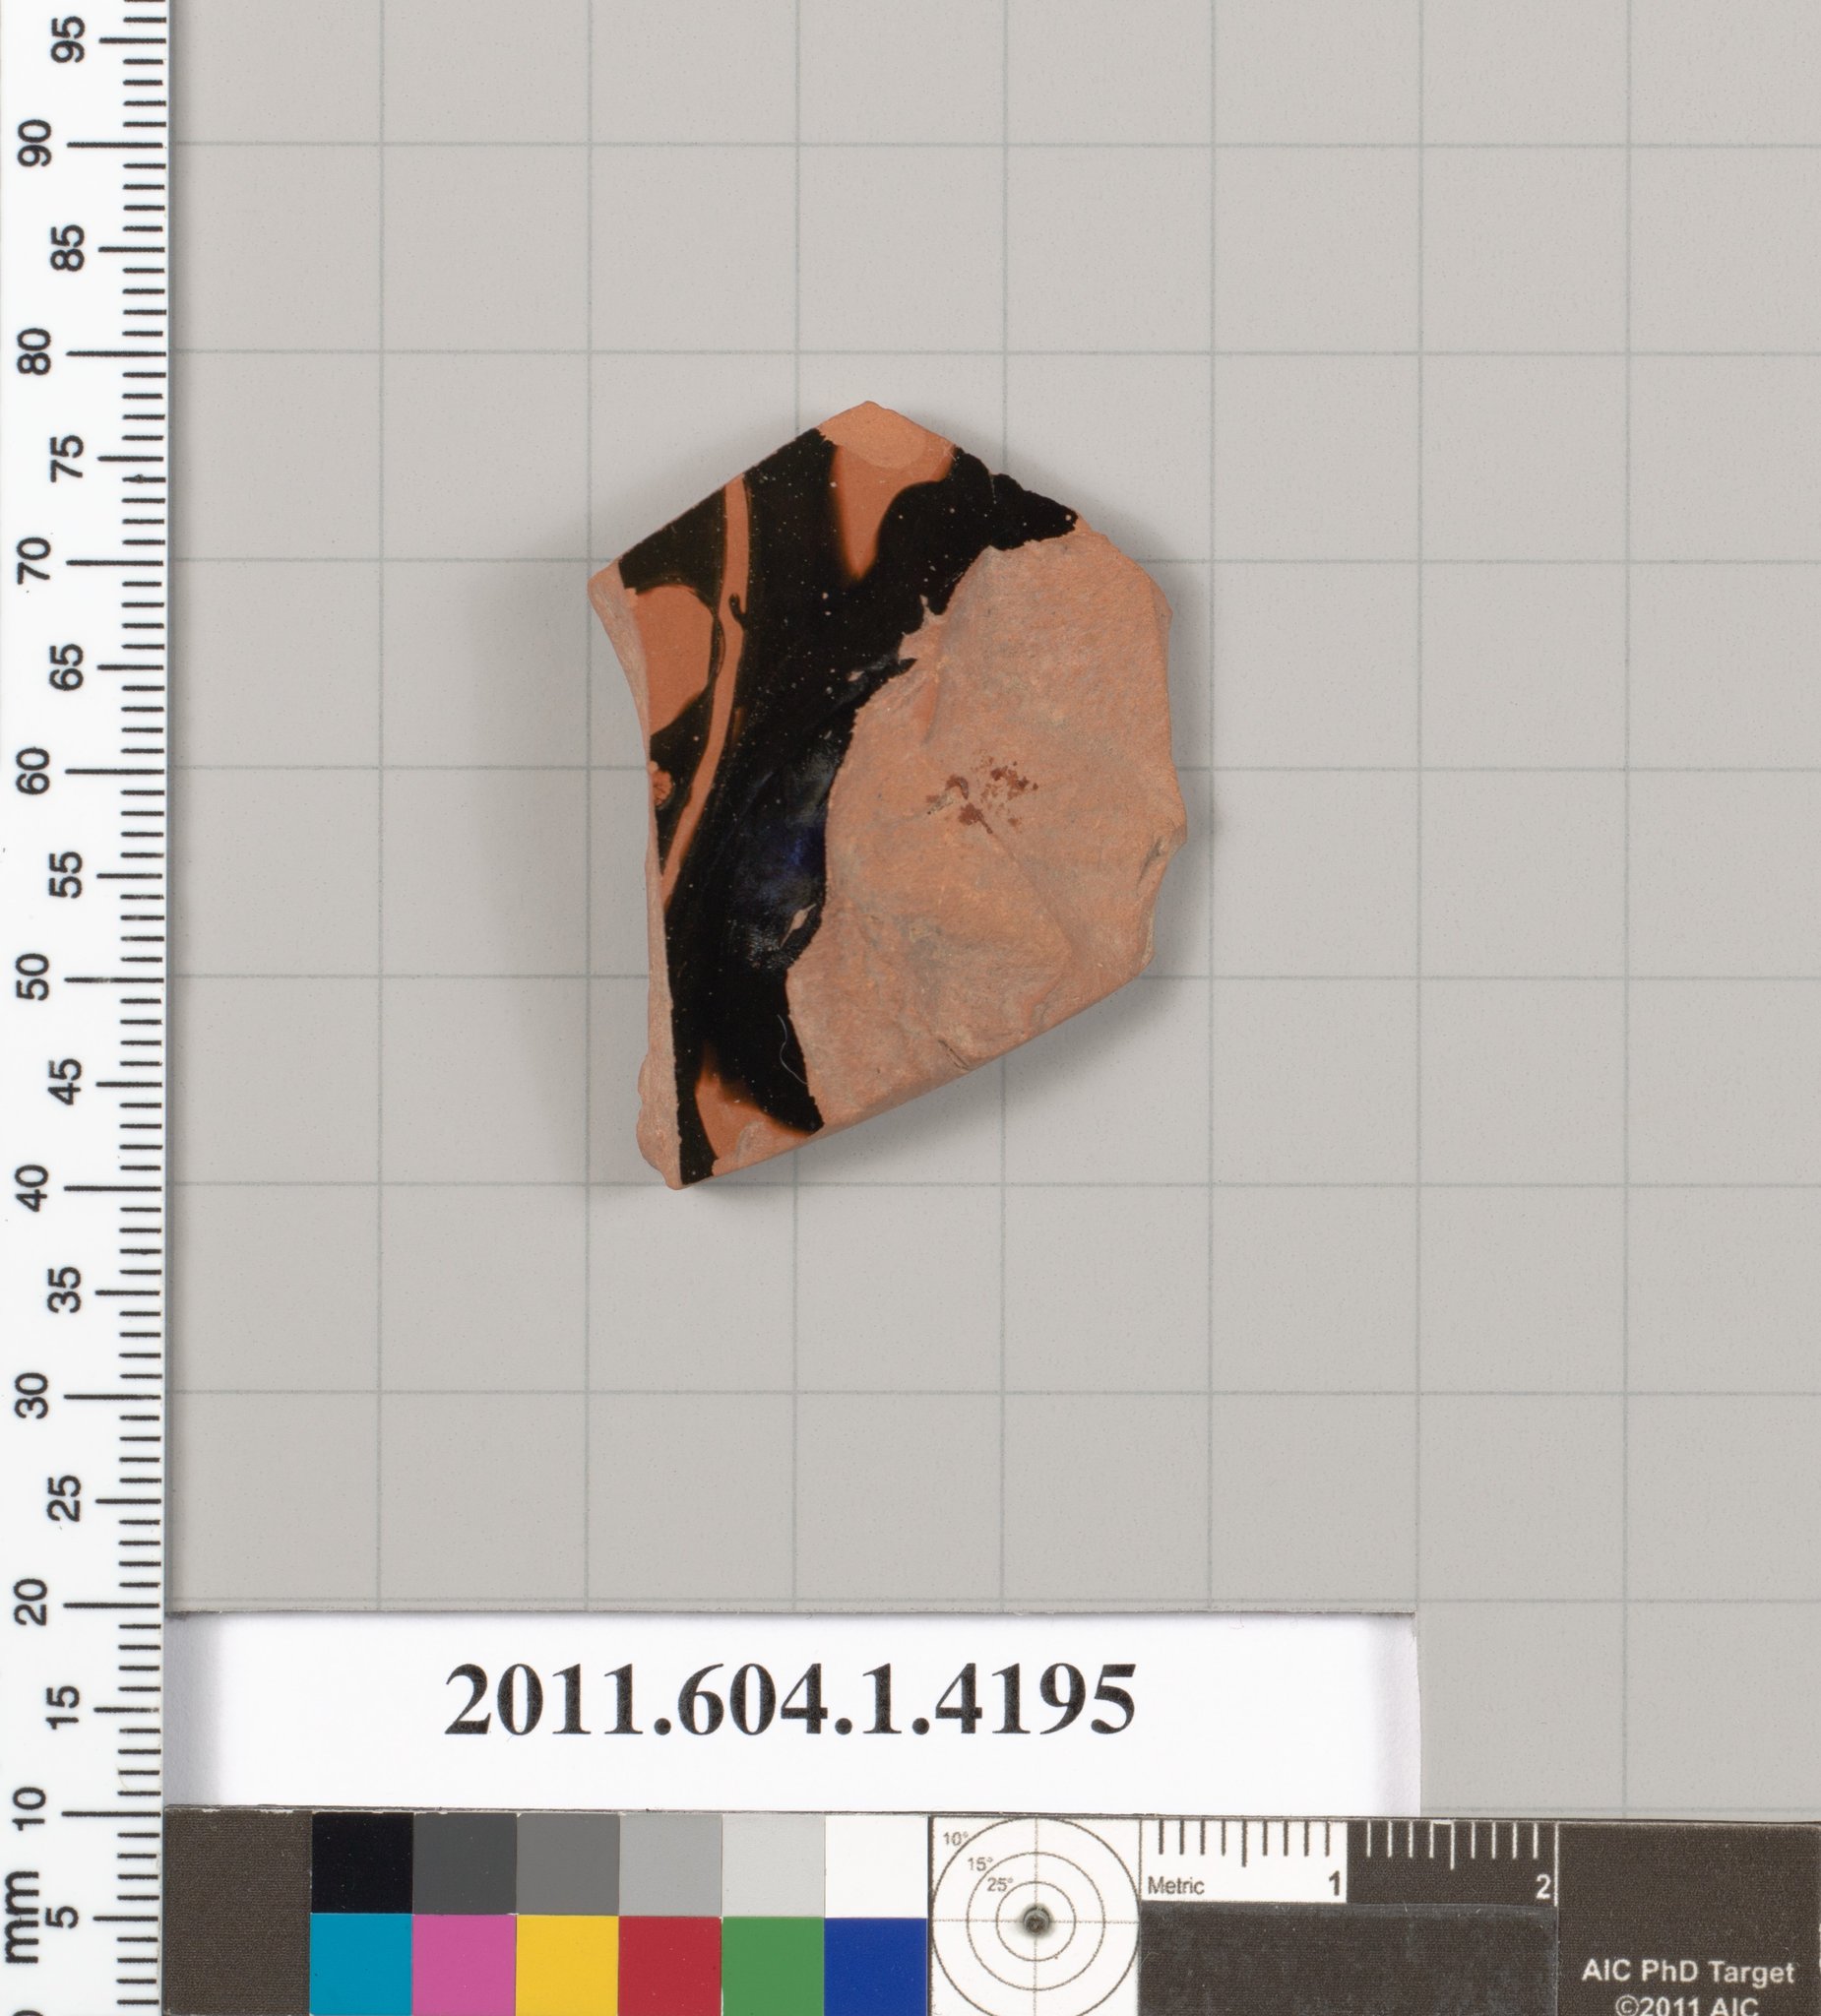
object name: kylix fragment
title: Terracotta fragment of a kylix (drinking cup)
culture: greek, attic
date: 500-476 BCE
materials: terracotta